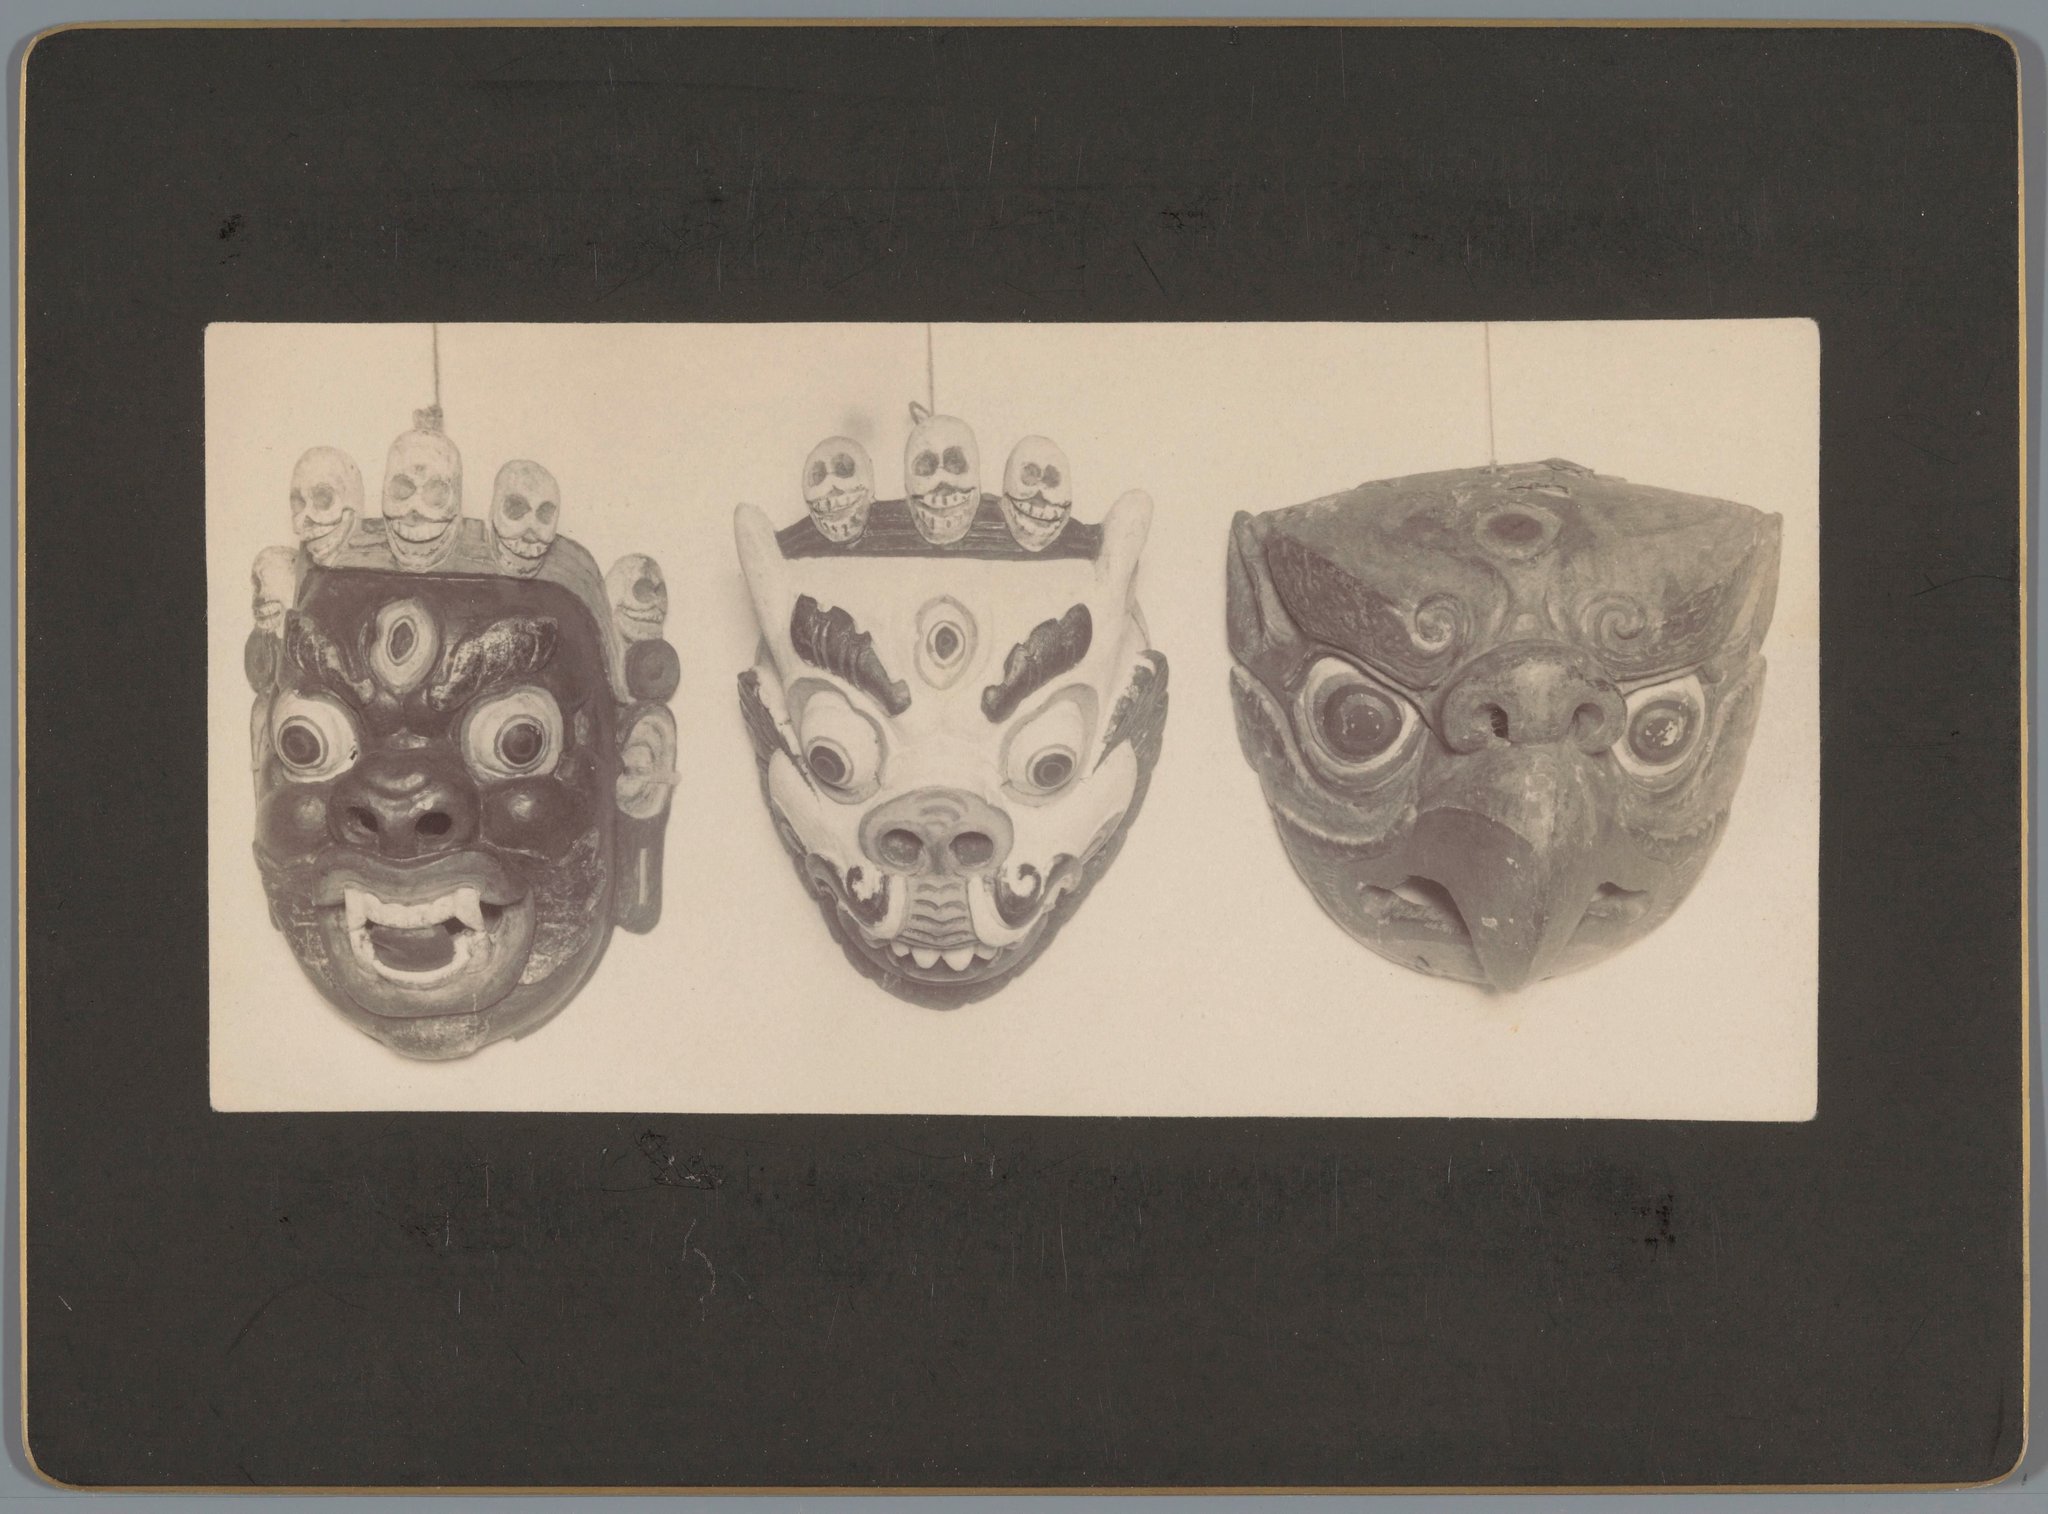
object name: photograph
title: Maskers voor den duivelsdans, Thibet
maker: Anonymous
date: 1897-1910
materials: cardboard, paper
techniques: albumen print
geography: tibet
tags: mask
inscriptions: inscription: ‘hout/ N44/ hout/ N51/ hout/ N50’